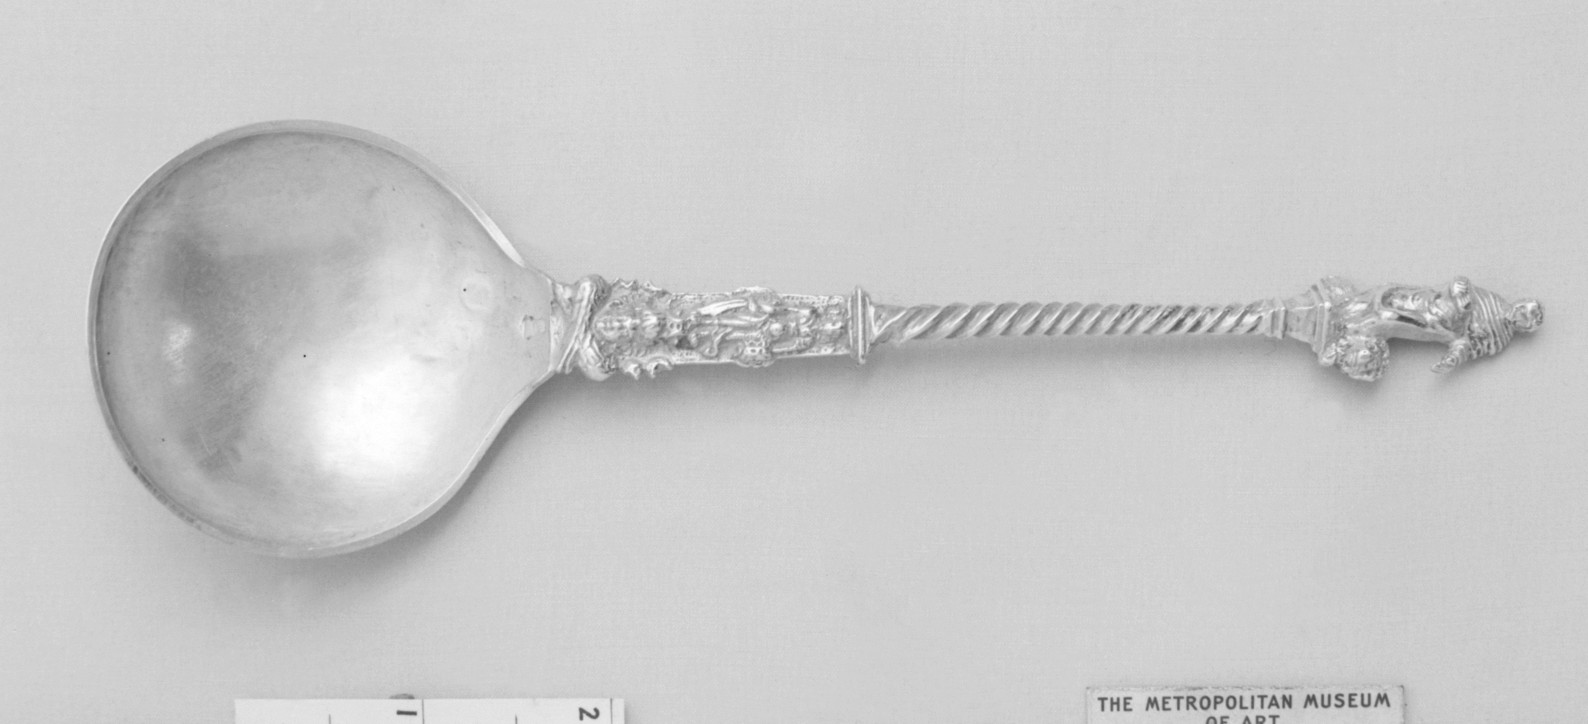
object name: apostle spoon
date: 1647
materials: silver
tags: apostles